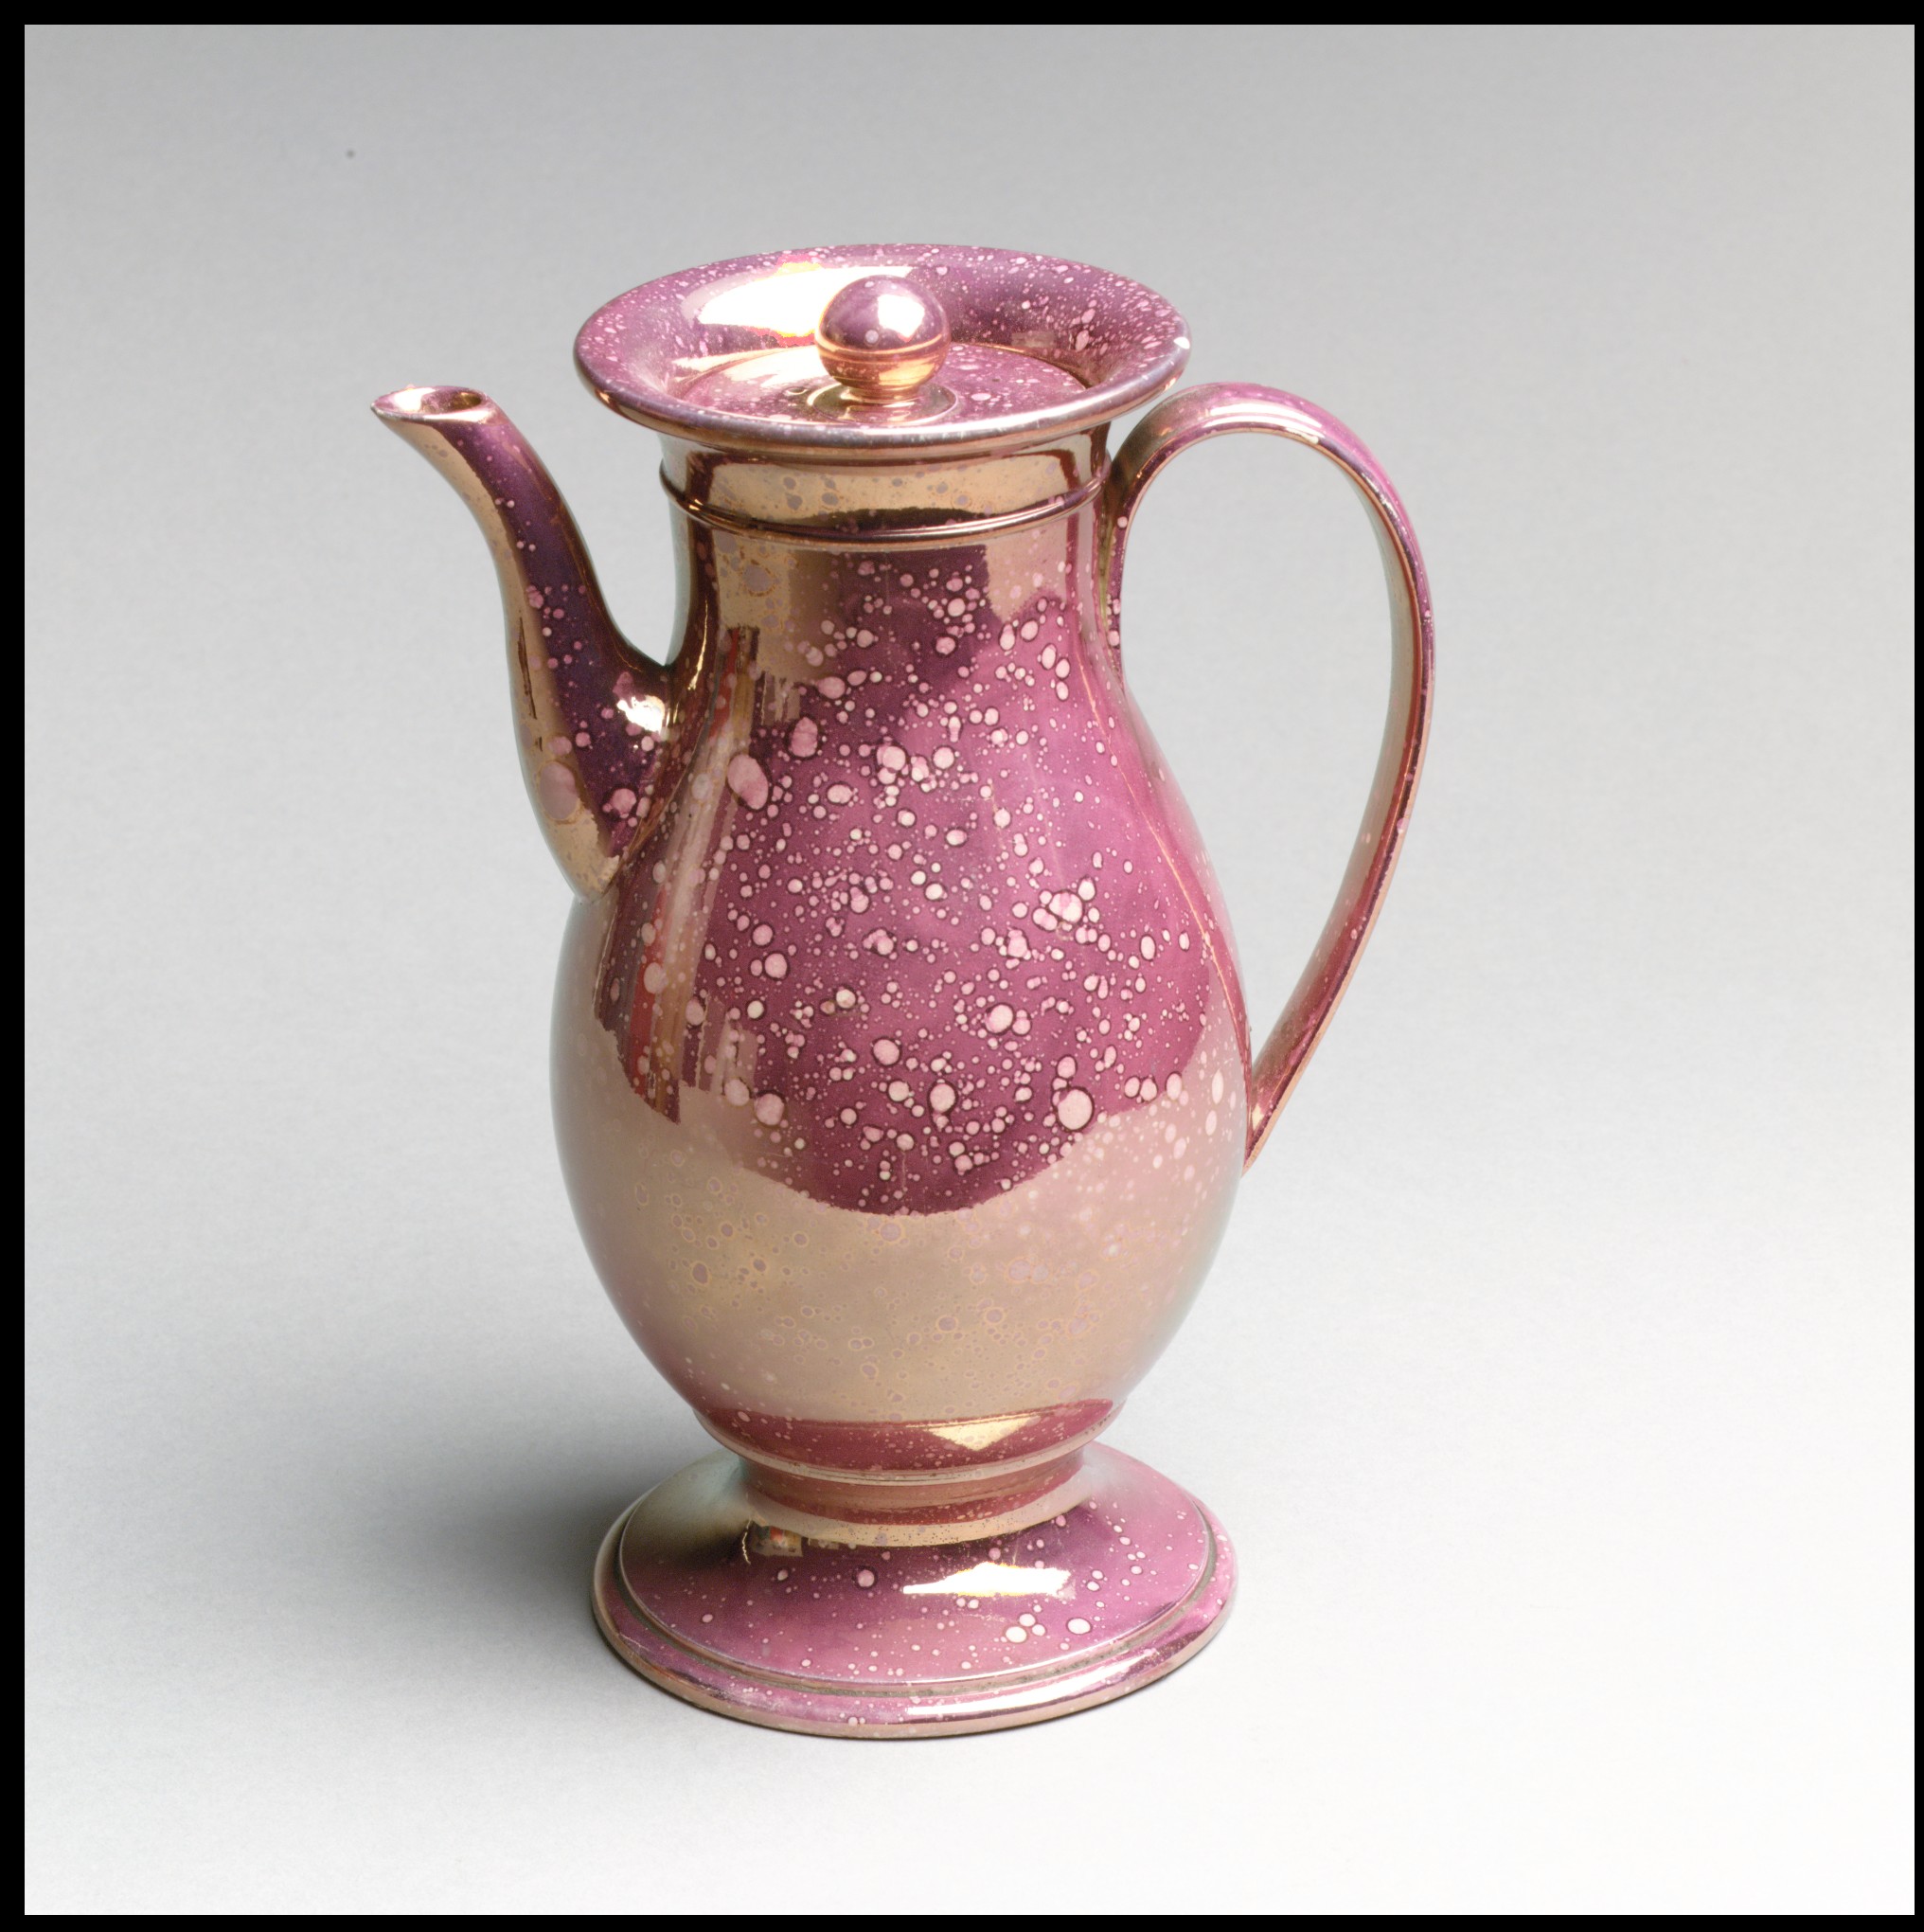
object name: coffee set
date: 1810